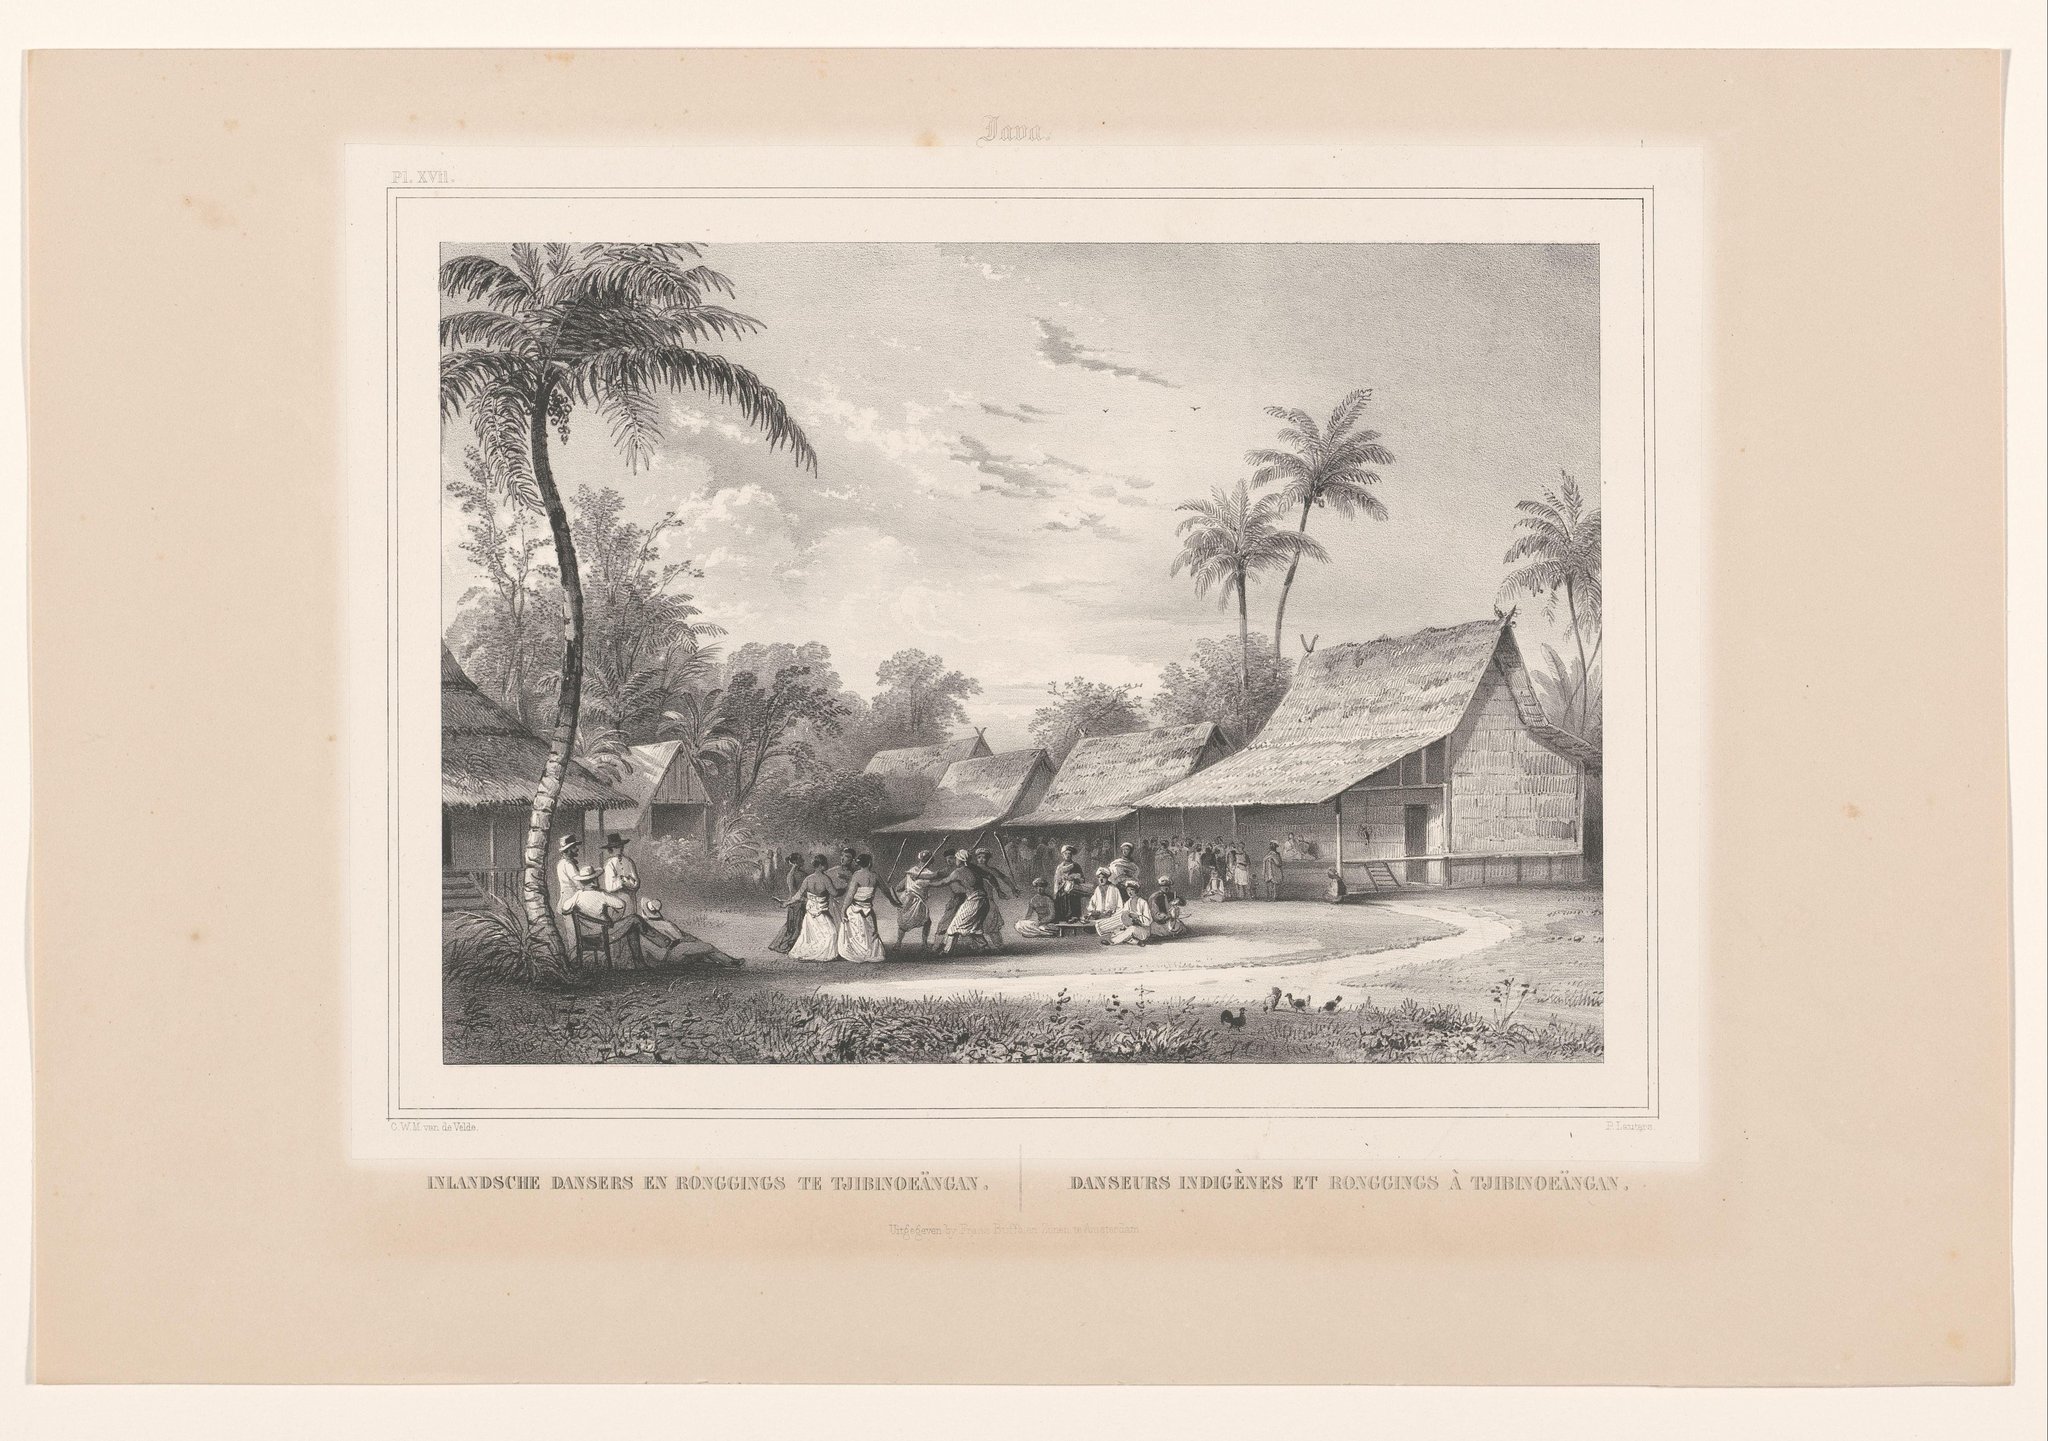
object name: print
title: Java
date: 1843-1845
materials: paper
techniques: lithograph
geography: indonesia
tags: group dancing, more than one musician with instrument, java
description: In het midden tussen de huizen dansen vrouwen en mannen. Daarbij zitten mannen op de grond met muziekinstrumenten. Links onder een boom kijkt een groepje mannen toe. Genummerd linksboven: Pl. XVII. De prent maakt deel uit van een omslag met vijf bladen.